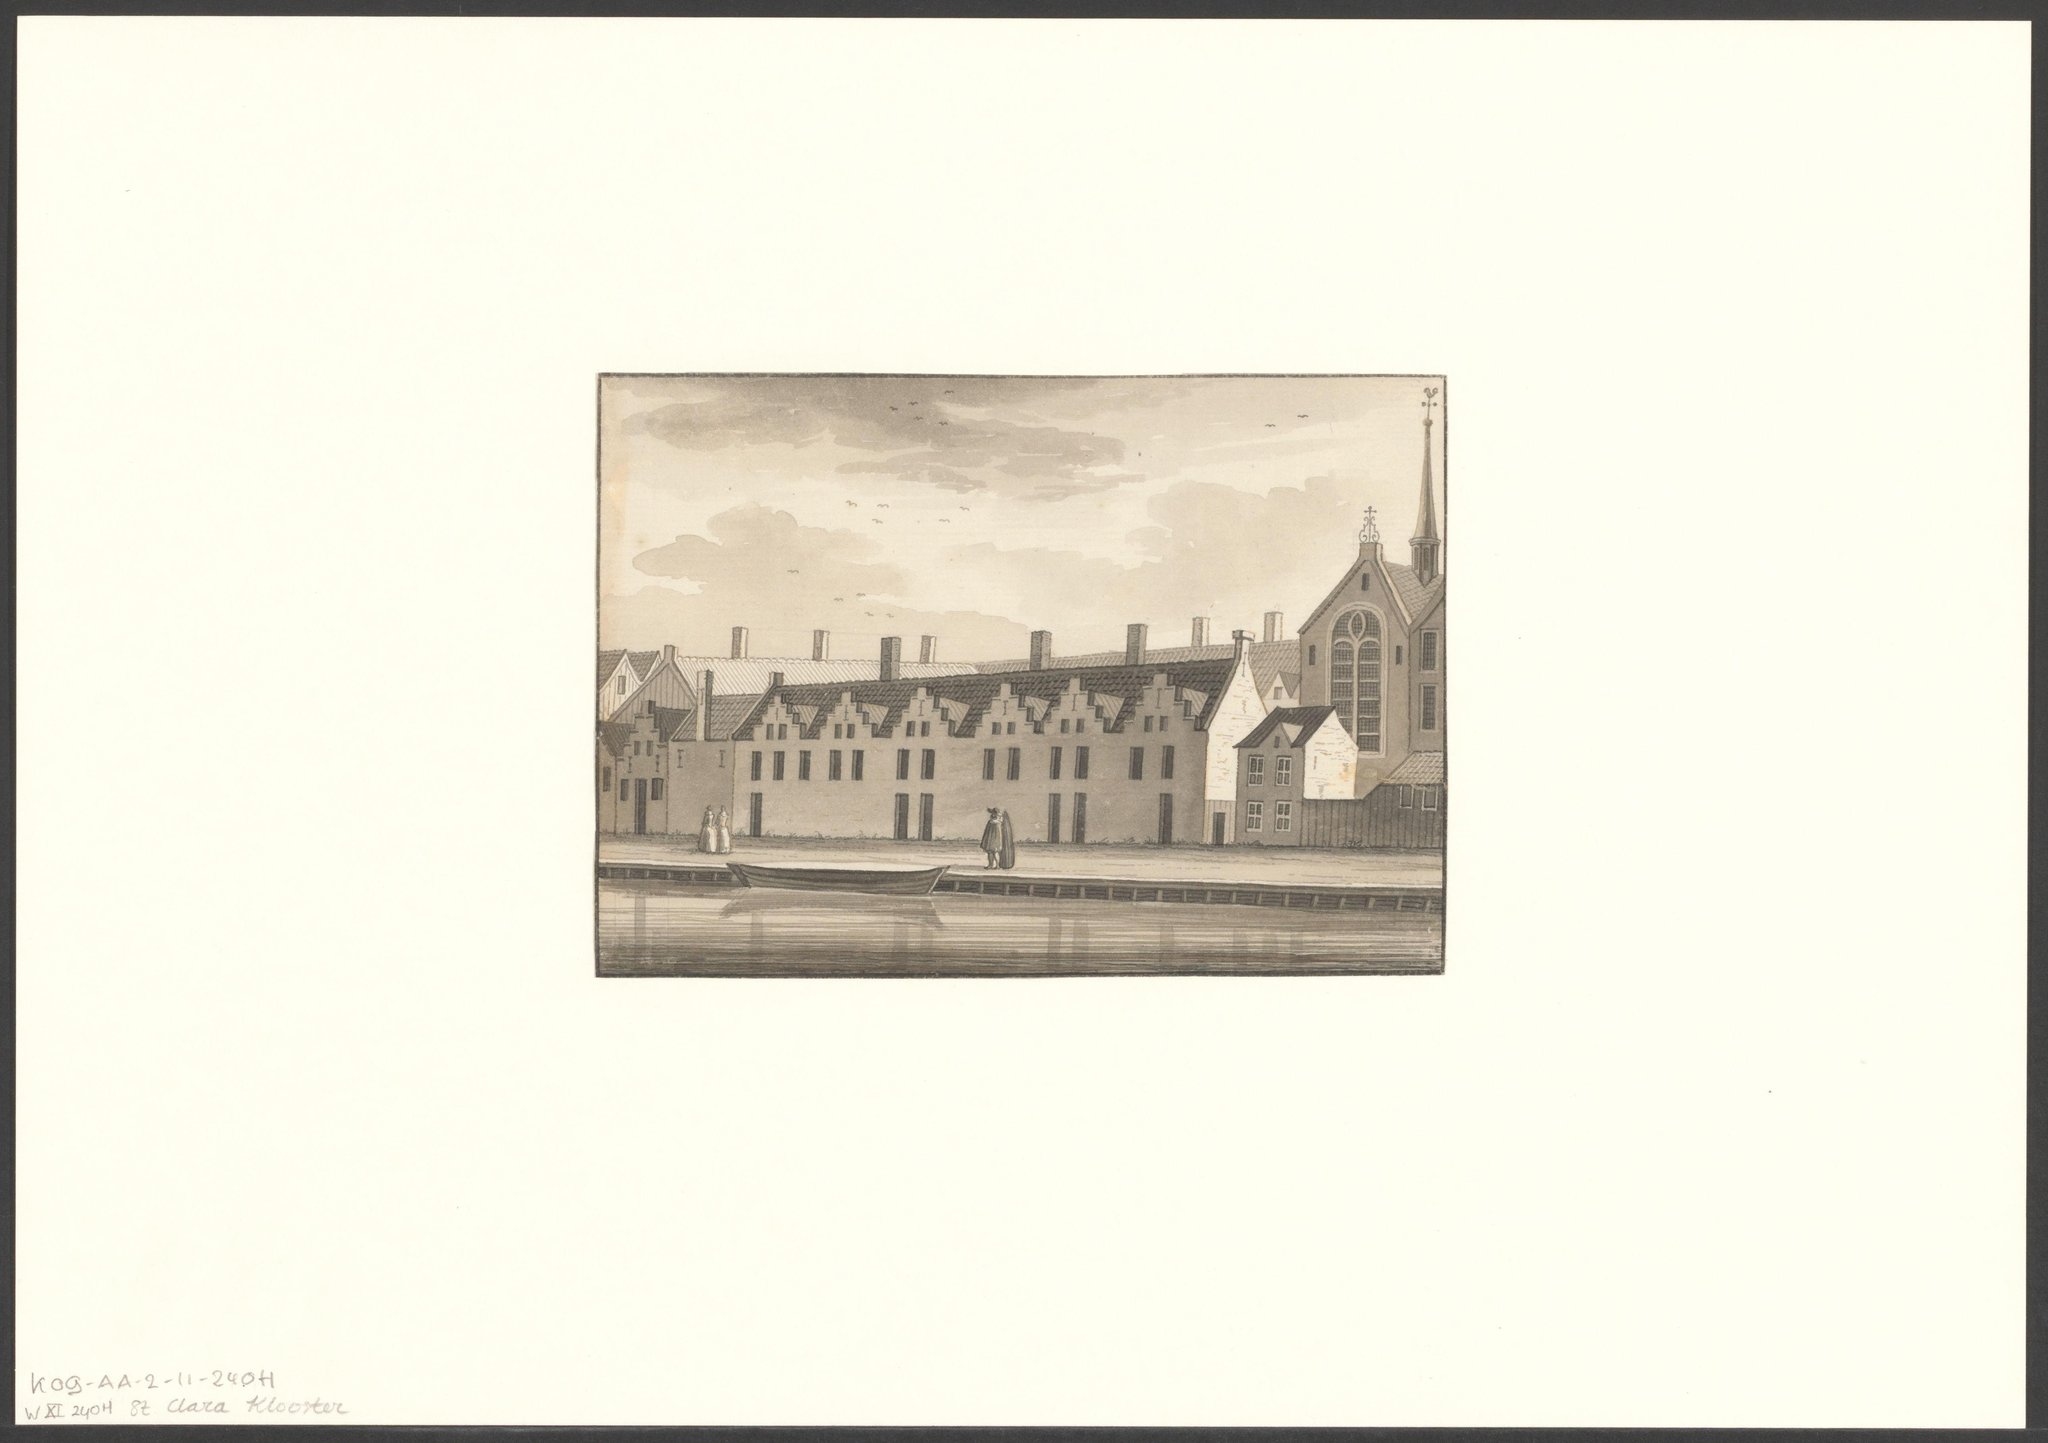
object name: drawing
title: Gezicht op het Sint Claraklooster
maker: Anonymous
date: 1700-1799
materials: ink, paper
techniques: brush, pen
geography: amsterdam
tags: city-view, and landscape with man-made constructions, canal, abbey, monastery, convent ~ roman catholic church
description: Tekening binnen de Atlas Van Eck ingedeeld op wijknummer 11.